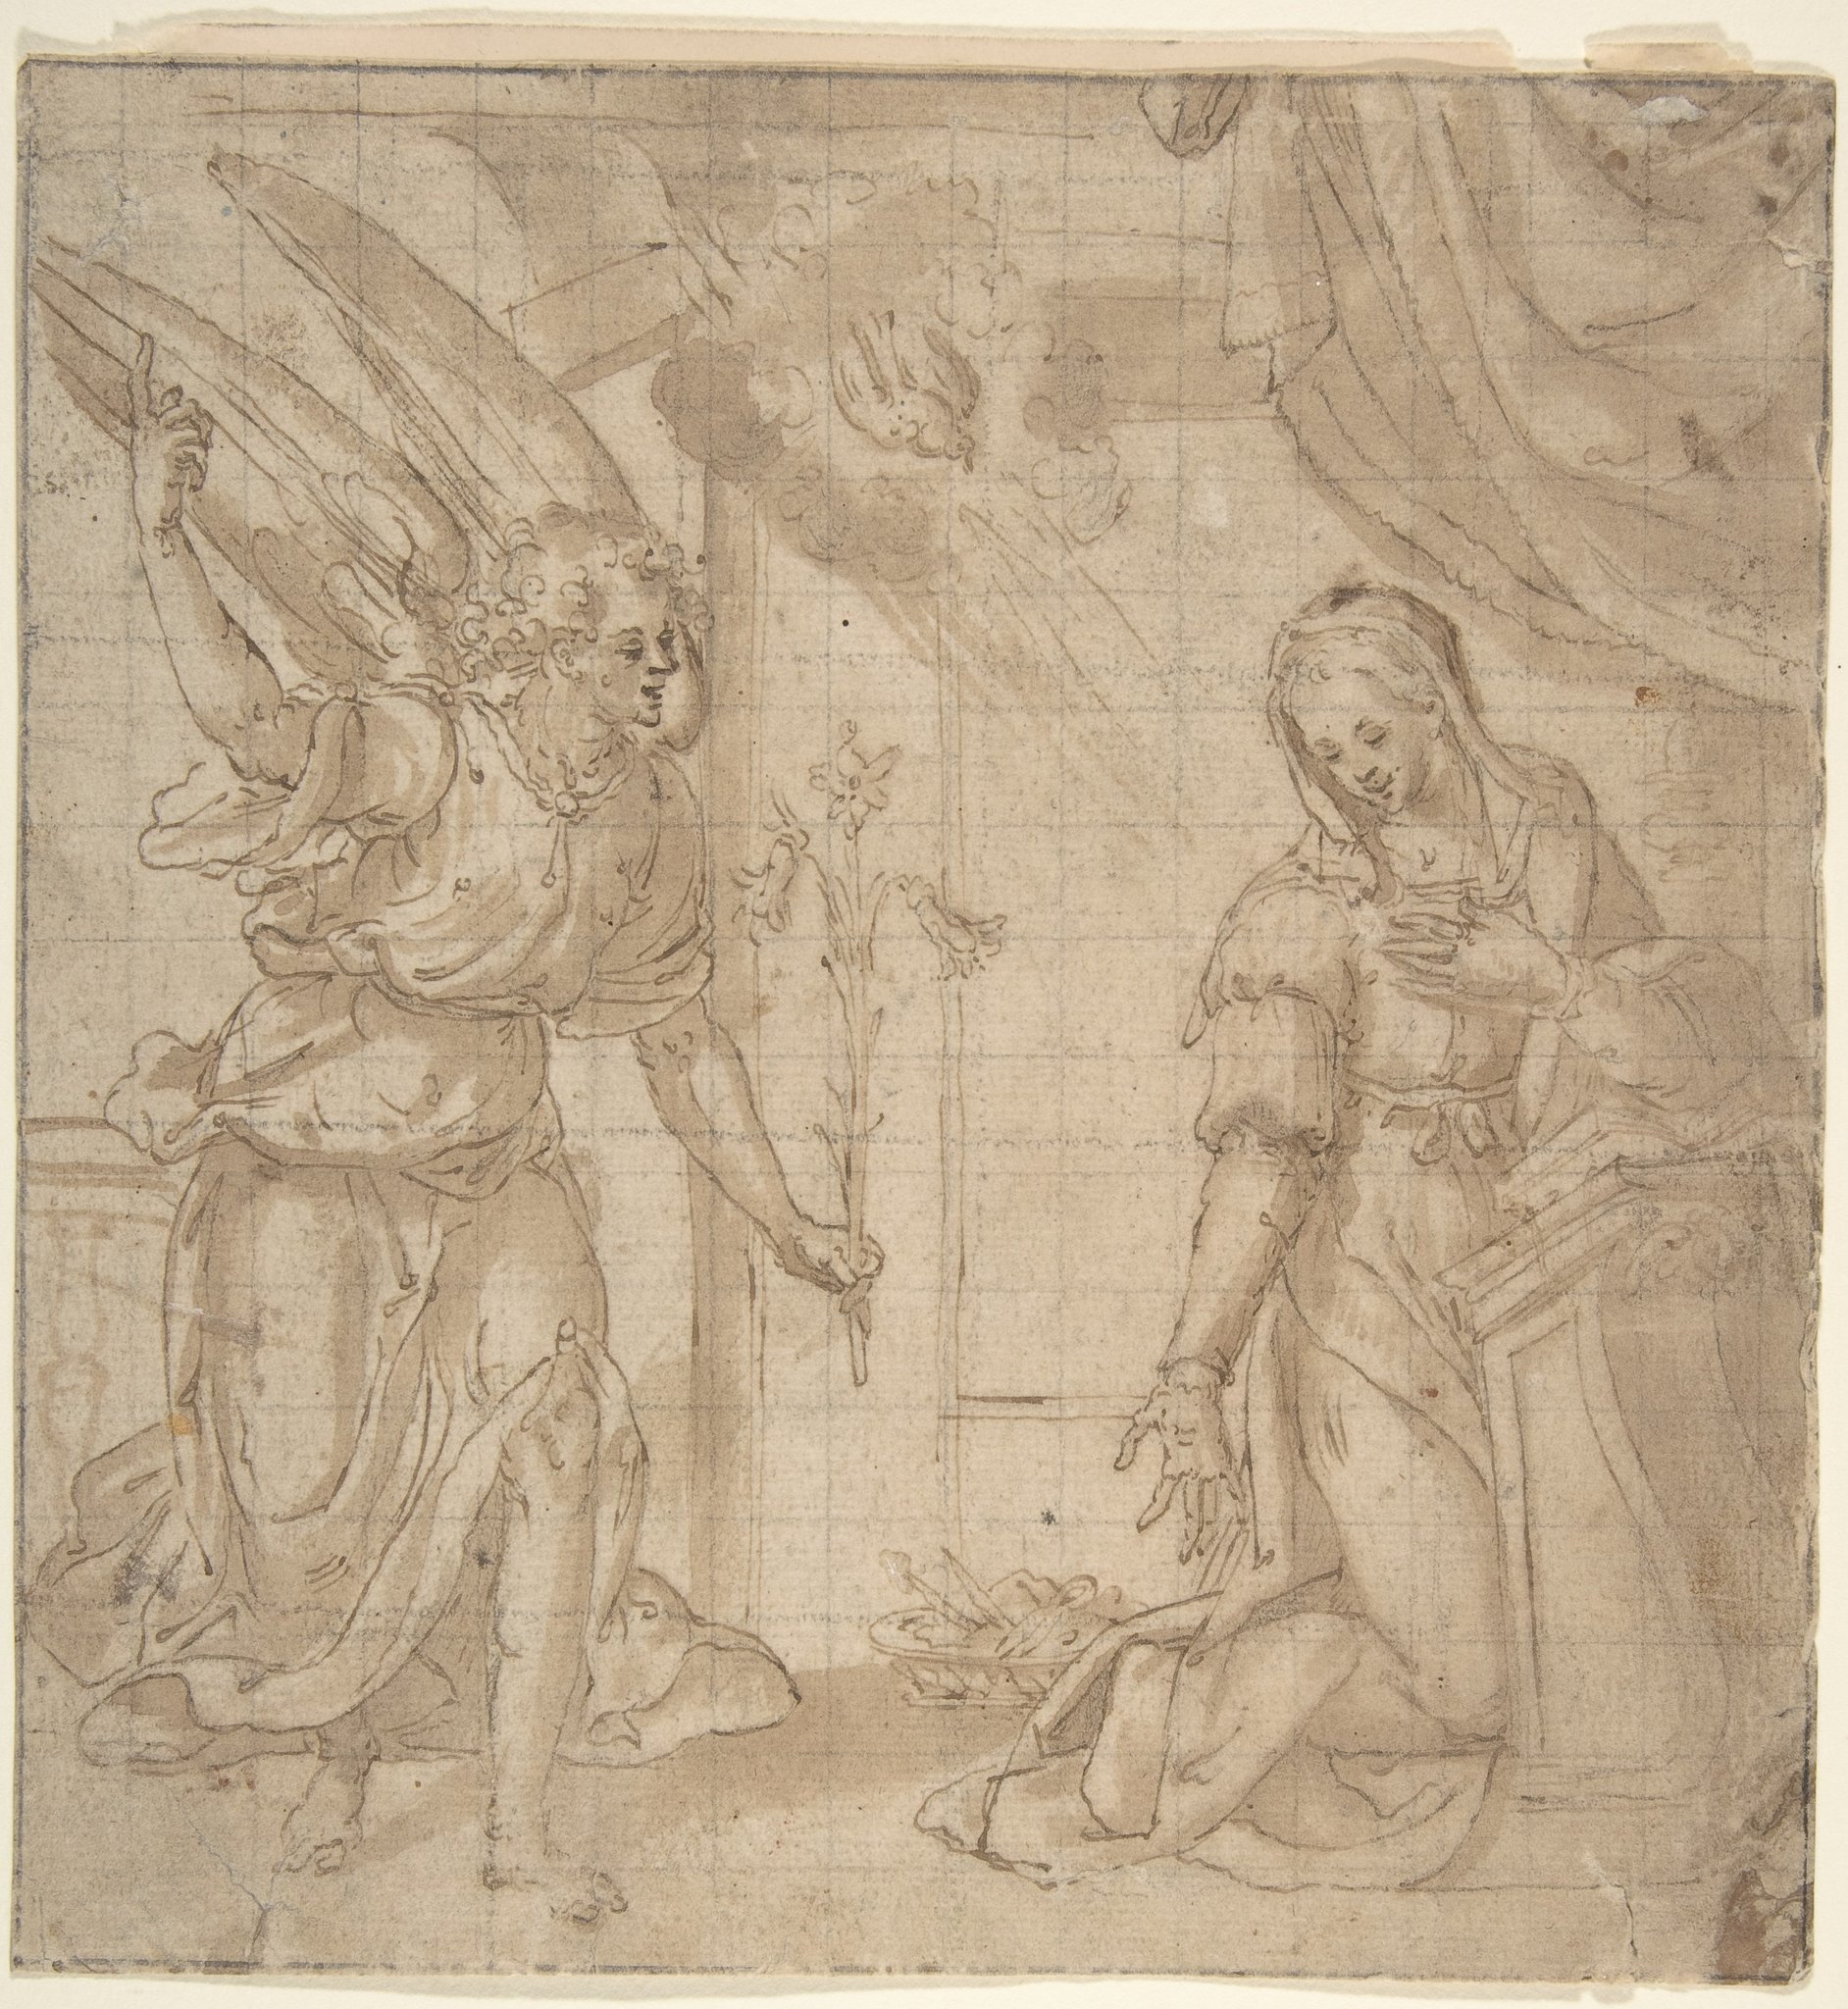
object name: drawing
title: Annunciation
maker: filippo bellini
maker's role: artist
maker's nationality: italian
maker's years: 1550-1604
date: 1560-1600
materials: chalk, ink, drawing material, paper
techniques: brush, pen, drawing, transfer, wash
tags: women,annunciation